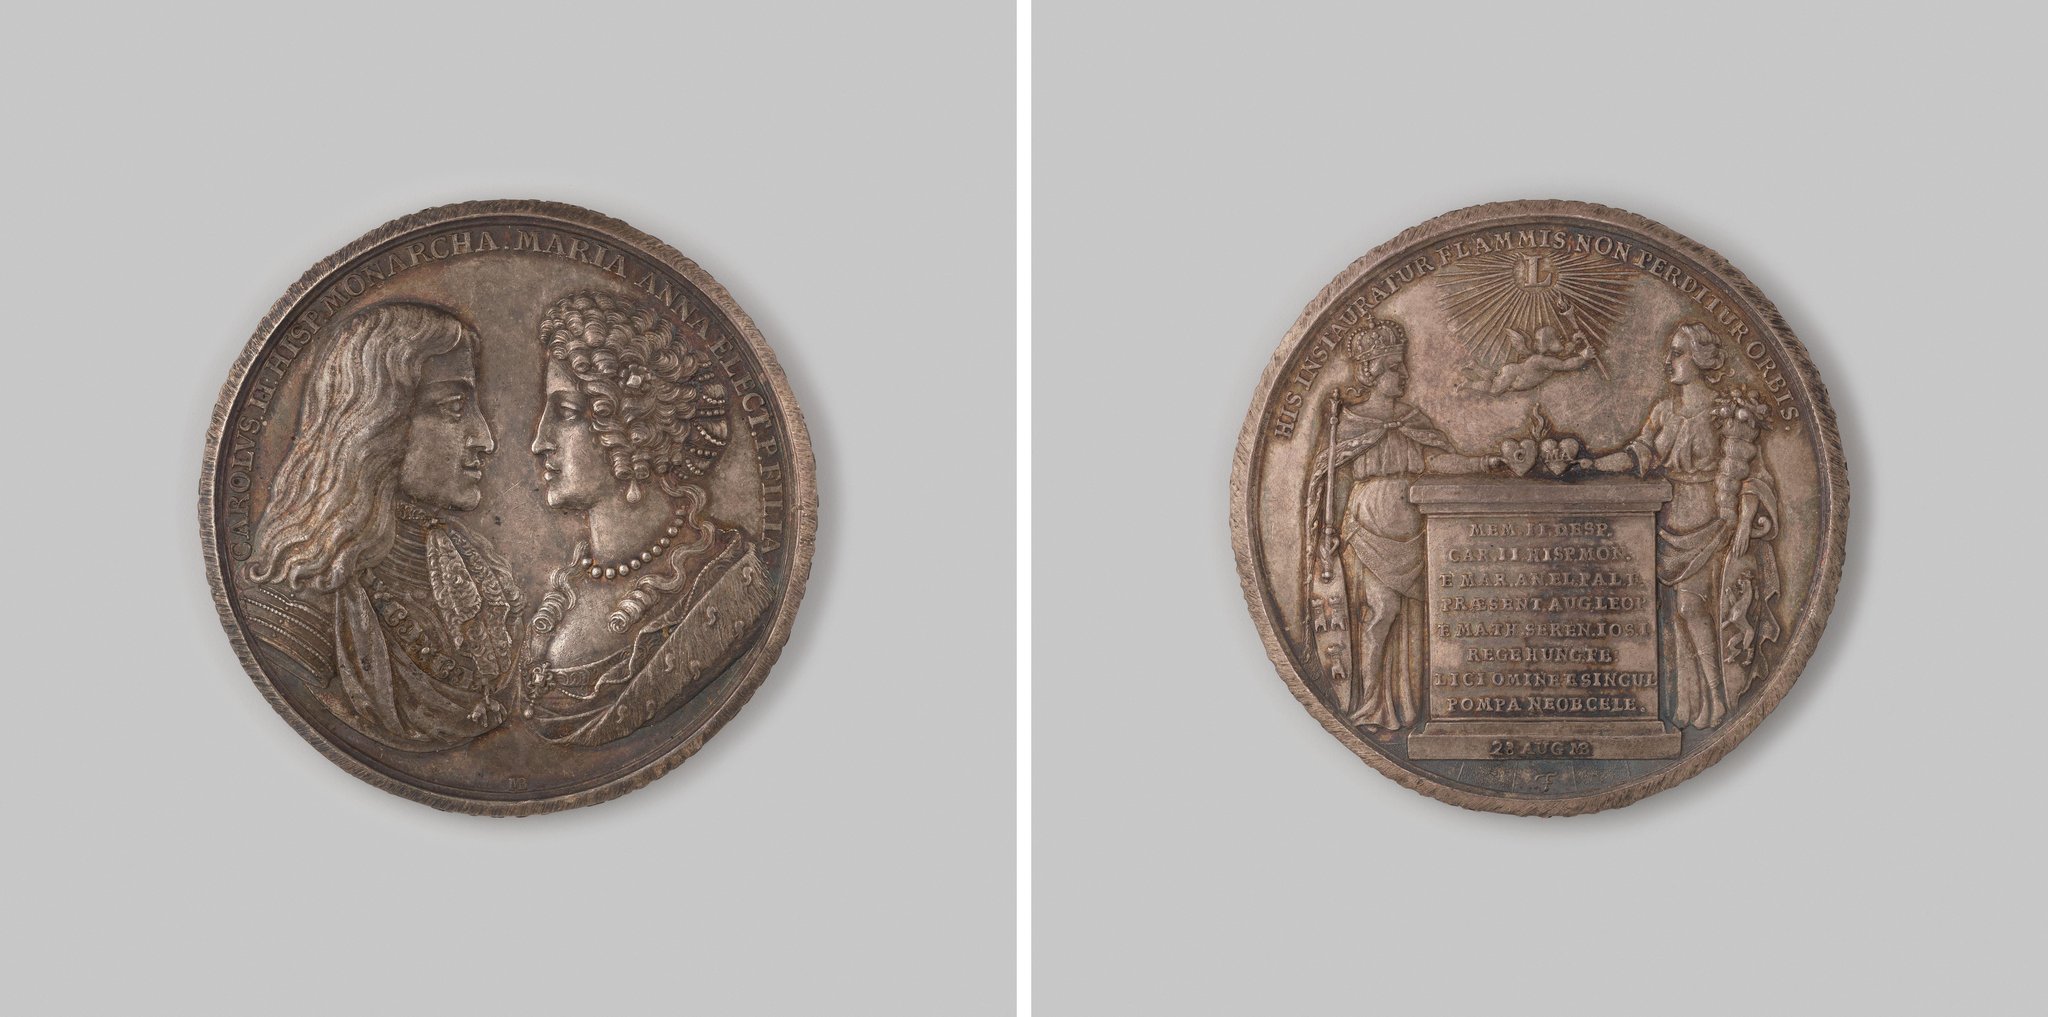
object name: history medal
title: Ondertrouw van Karel II van Spanje en Maria Anna van Neuburg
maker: monogrammist mb (medailleur)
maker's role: medailleur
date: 1689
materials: silver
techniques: striking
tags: karel ii (koning van spanje)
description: Zilveren penning. Voorzijde: borststuk man en vrouw binnen omschrift. Keerzijde: twee vrouwen waarvan ene met kroon en scepter en andere met hoorn van overvloed houden ieder brandend hart op altaar met opschrift binnen omschrift; randschrift